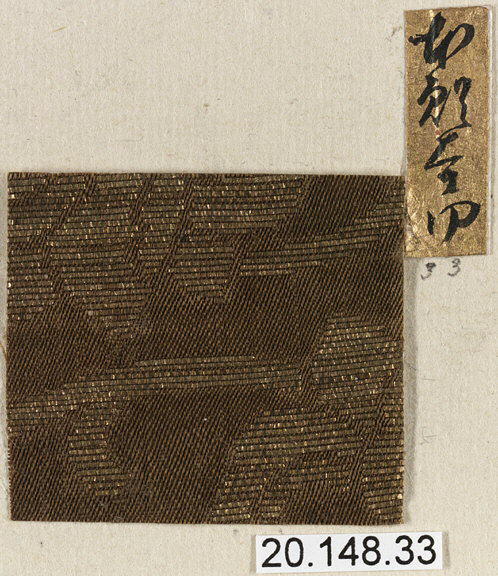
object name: piece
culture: japanese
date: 1501-1600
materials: silk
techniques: compound weave